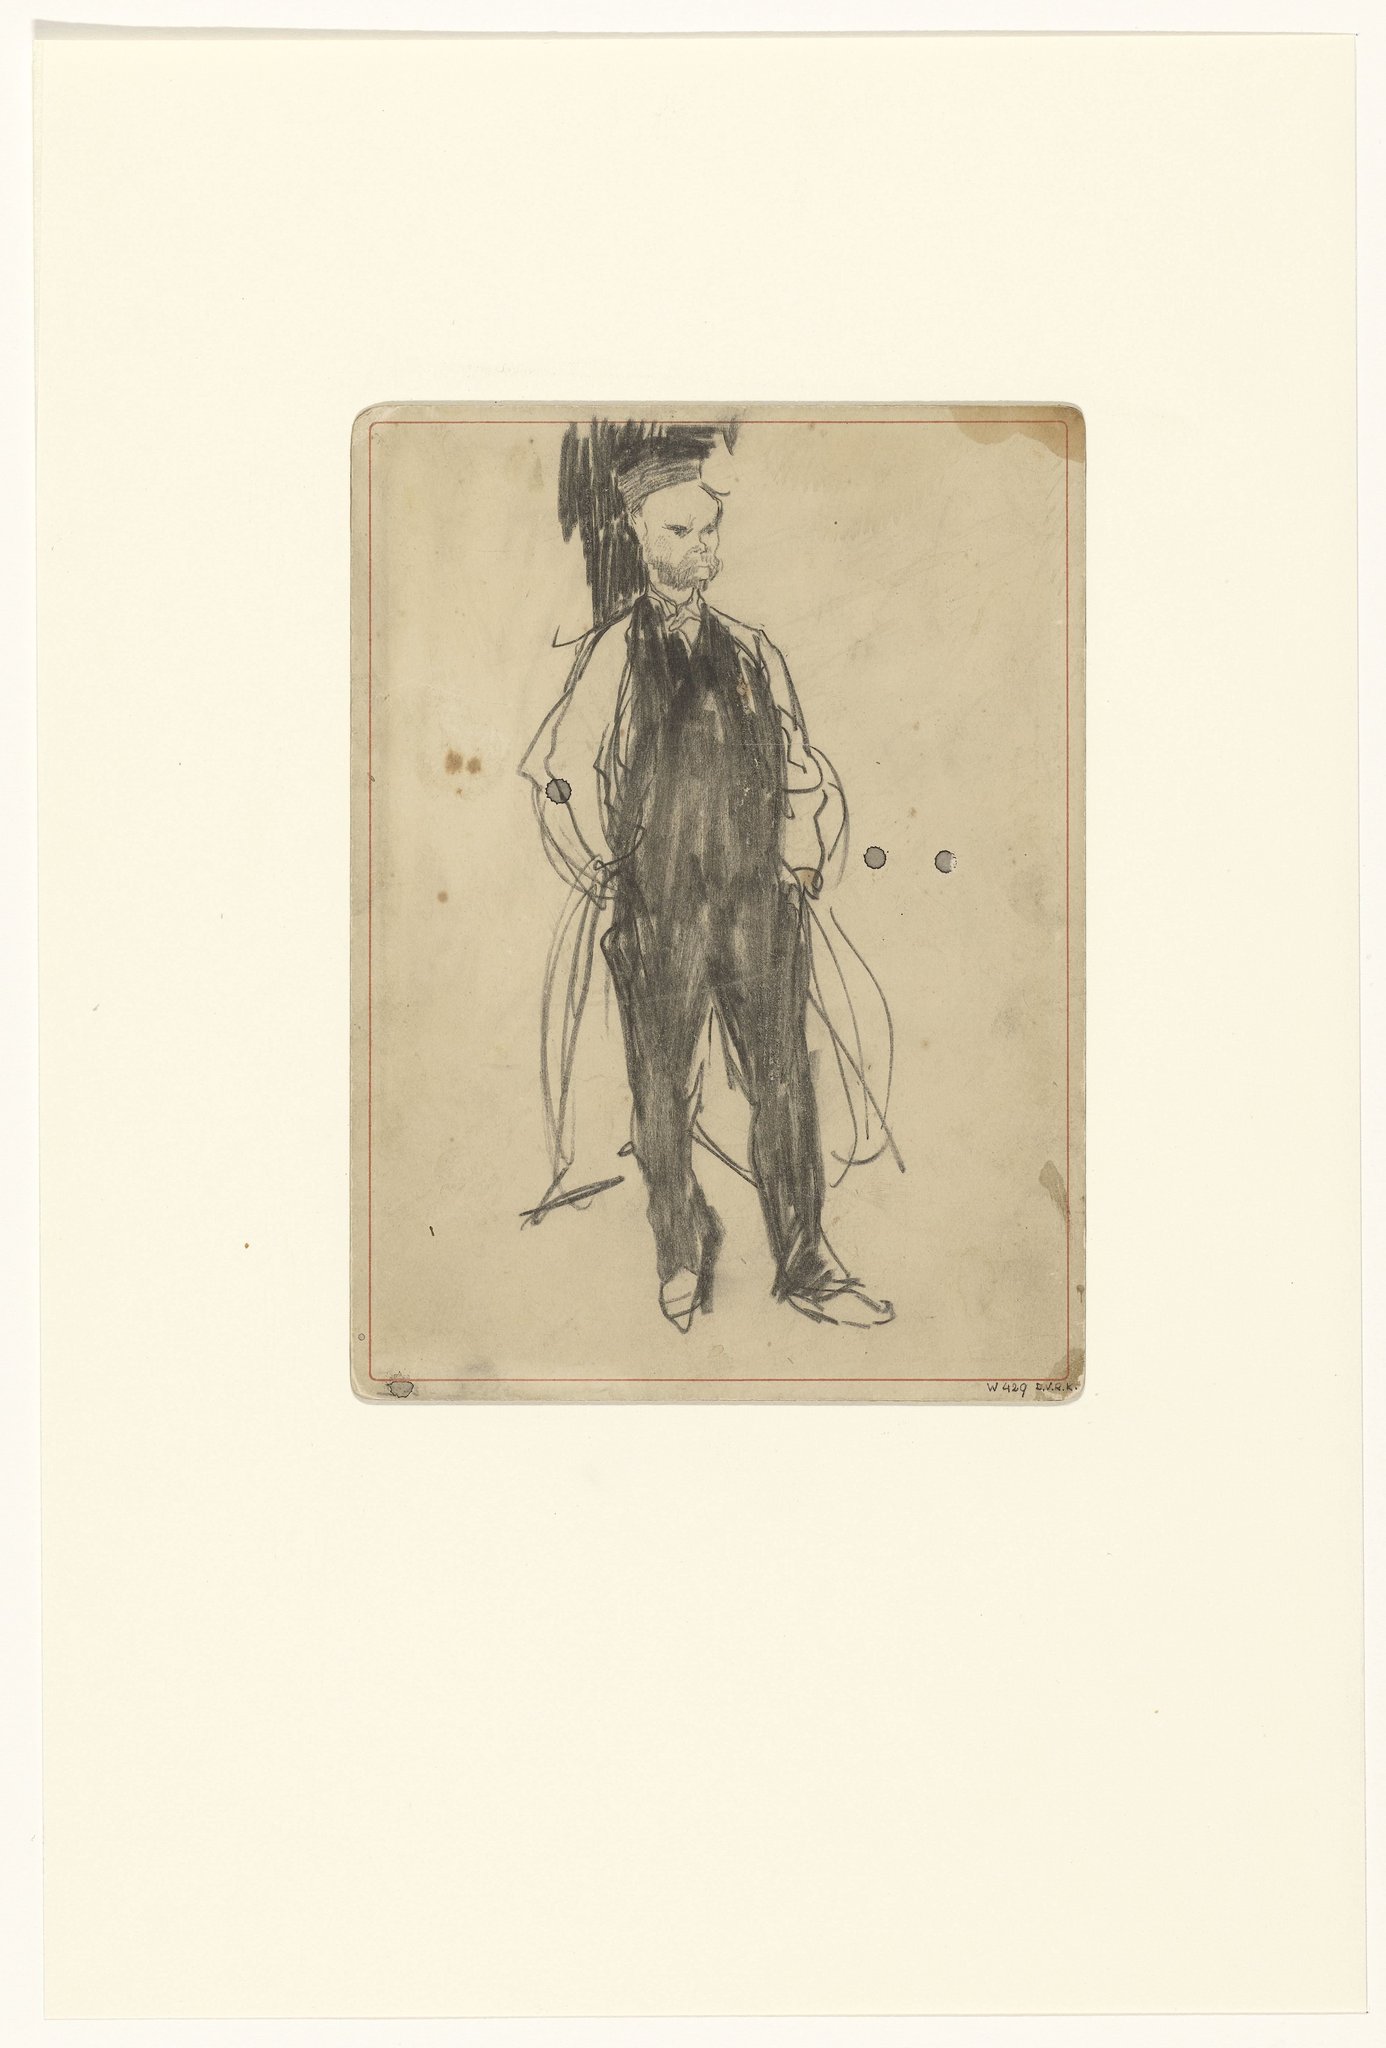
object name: drawing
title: Paul Verlaine, staande met de handen in de zakken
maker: isaac israels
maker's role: draughtsman, painter, print maker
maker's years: 1865-1934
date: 1892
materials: chalk, paper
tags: paris, paul verlaine, historical persons, portrait of a writer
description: Paul Verlaine, staande met de handen in de zakken. Geportretteerd in zijn sjamberloek.